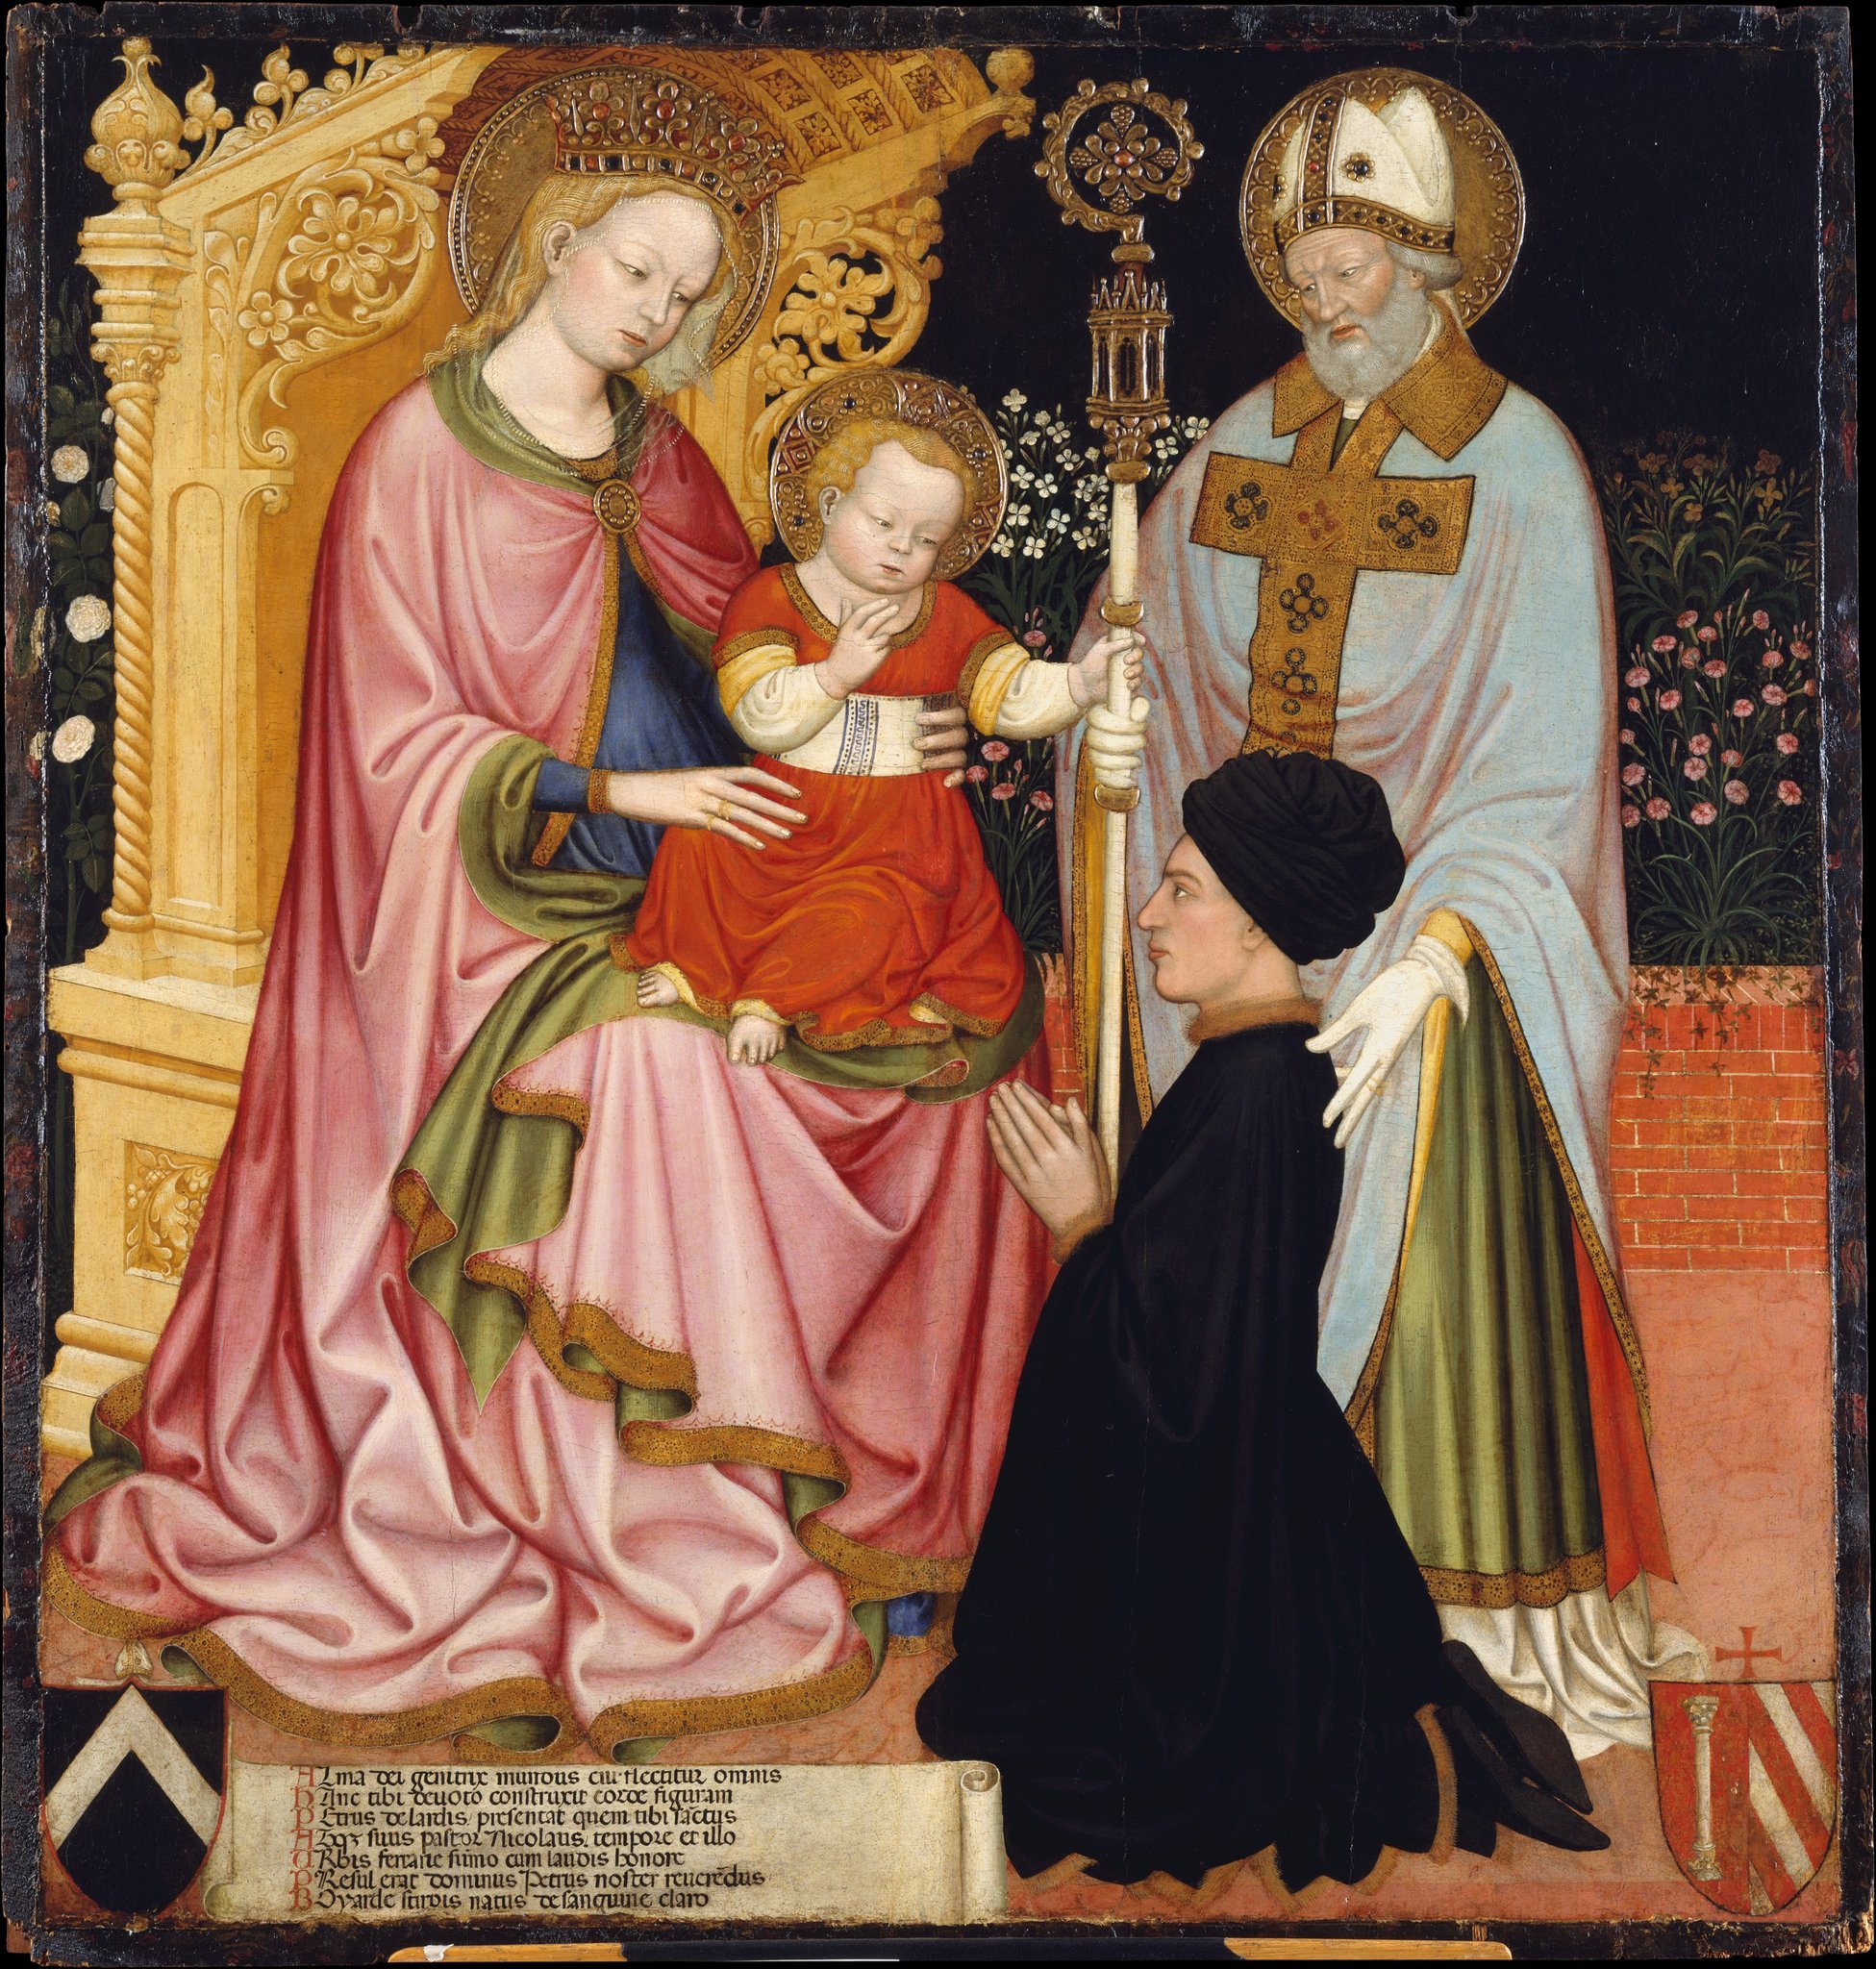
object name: painting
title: Madonna and Child with the Donor, Pietro de' Lardi, Presented by Saint Nicholas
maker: master g.z. (possibly michele dai carri, italian, ferrara, active by 1405–died 1441 ferrara)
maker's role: artist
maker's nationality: italian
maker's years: 1405-1441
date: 1420-1430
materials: gold, paint, wood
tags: men,madonna and child,coat of arms,saint nicholas